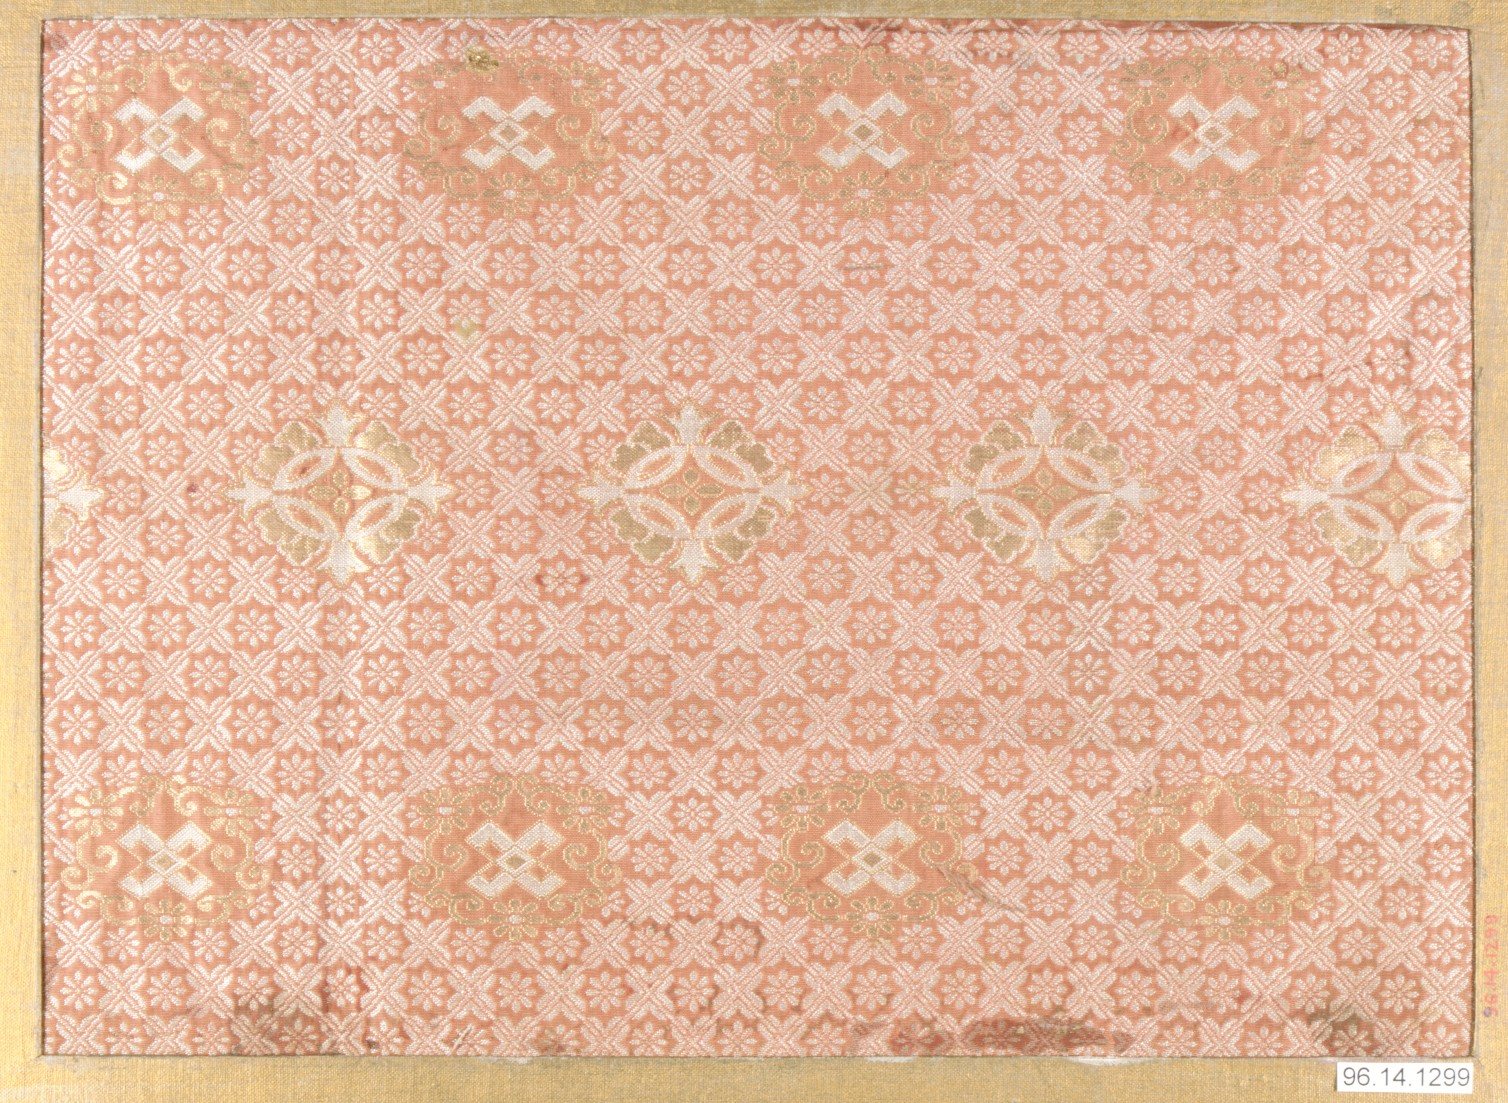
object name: piece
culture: japanese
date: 1701-1900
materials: silk